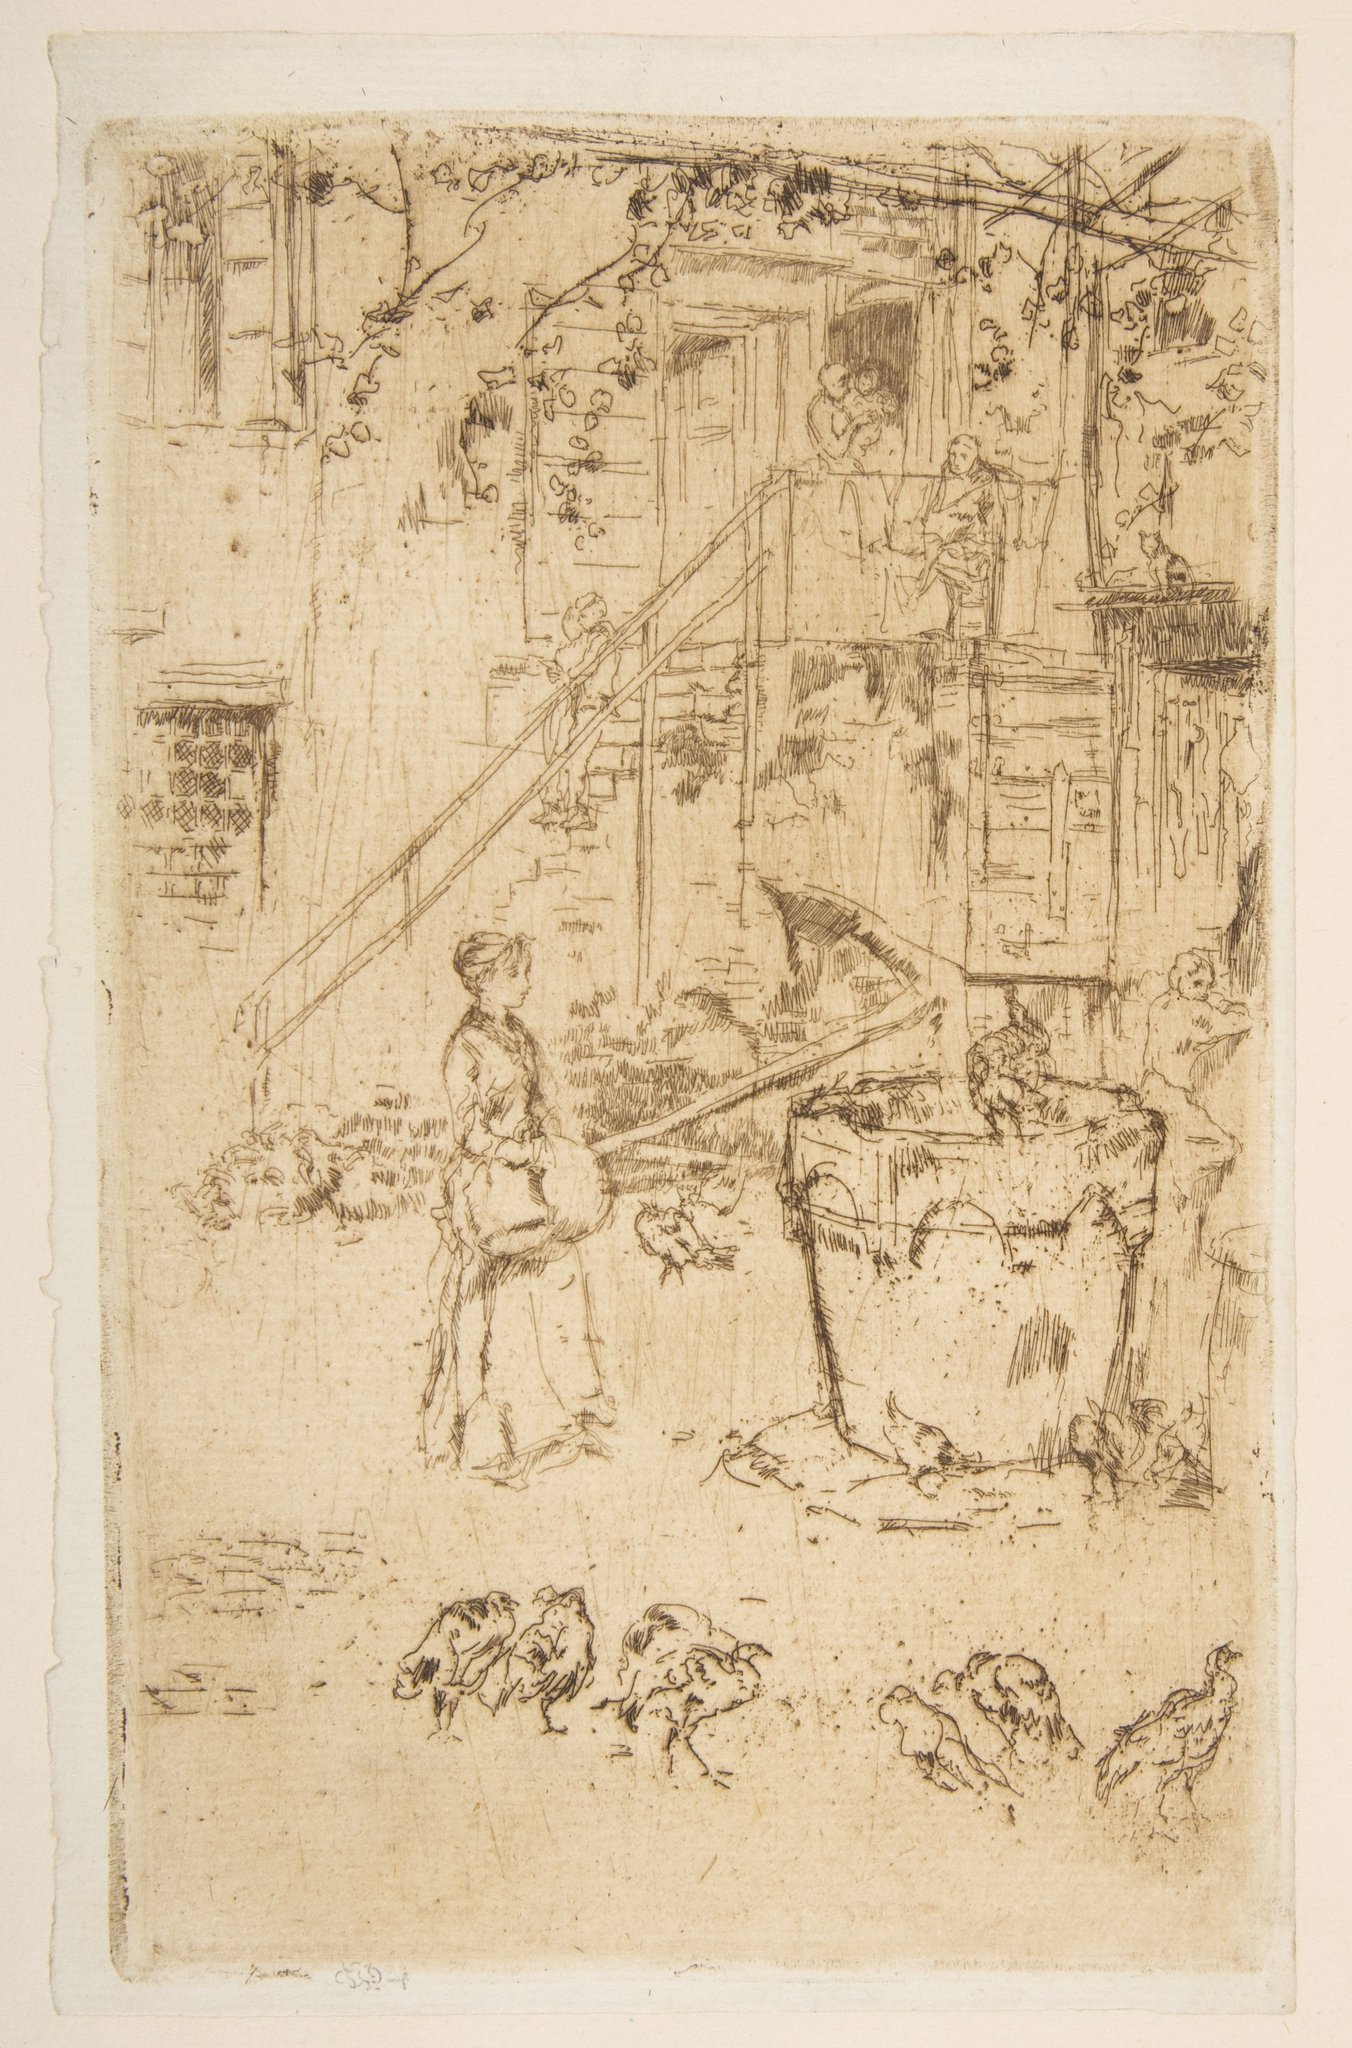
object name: print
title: Turkeys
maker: james mcneill whistler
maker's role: artist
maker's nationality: american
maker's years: 1834-1903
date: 1879-1880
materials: ink, paper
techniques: drypoint, etching, printing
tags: women,turkeys,venice